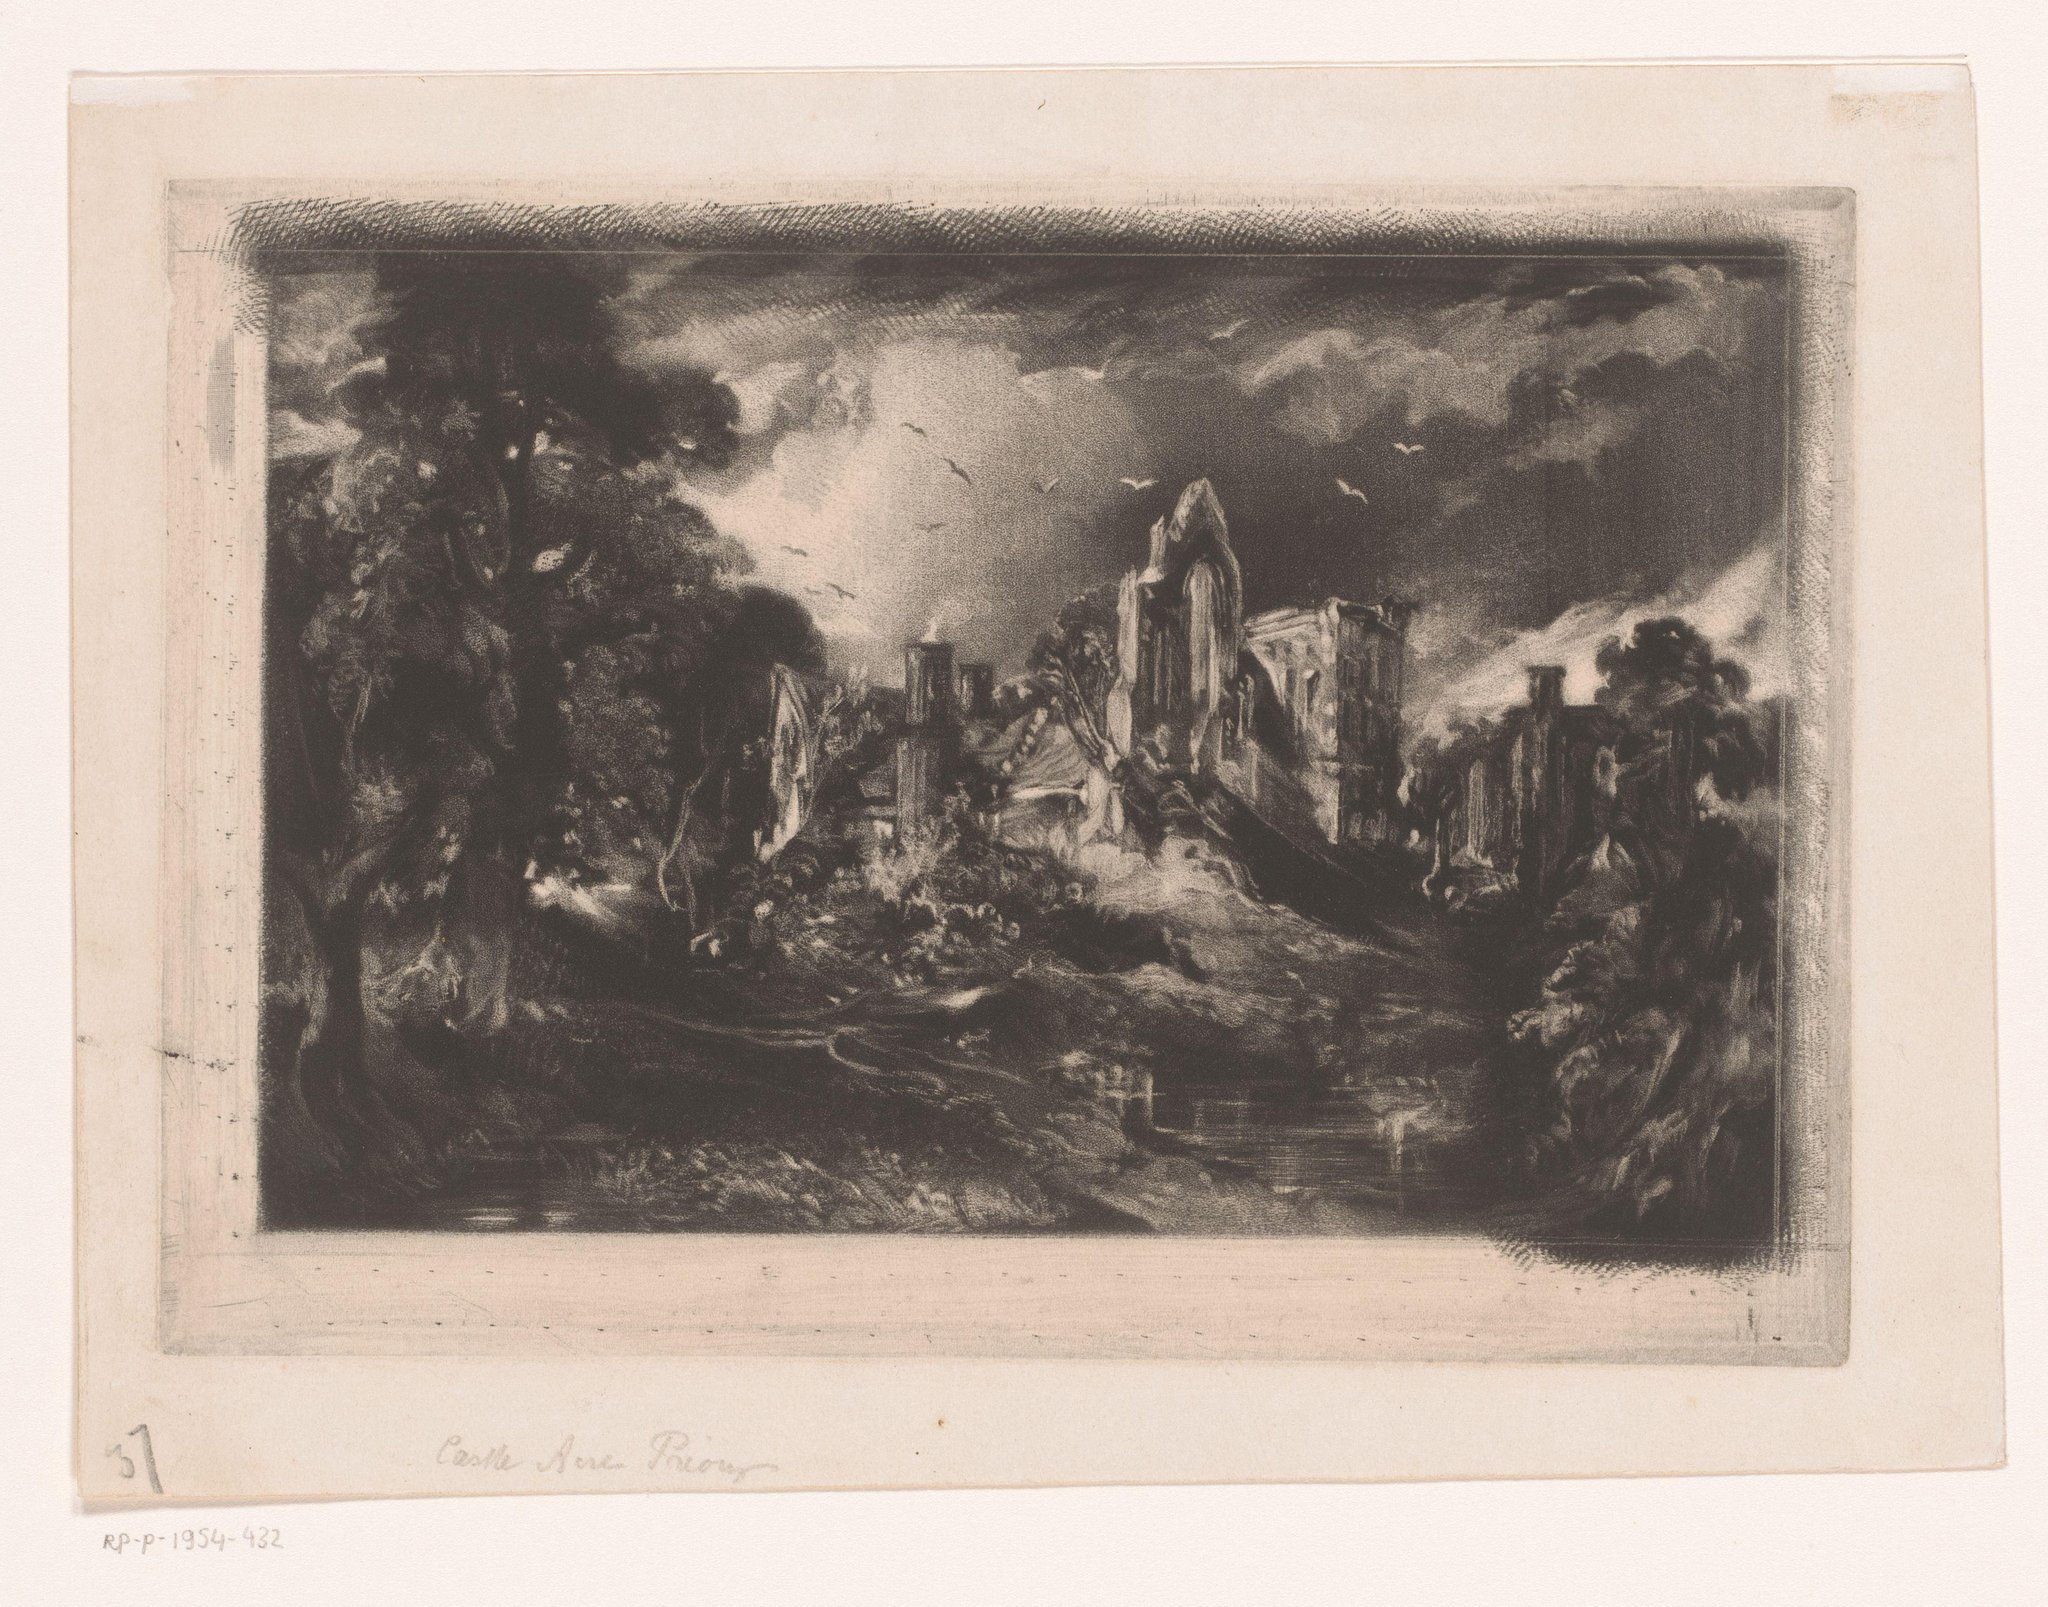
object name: print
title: Castle Acre Priory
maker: david lucas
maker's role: print maker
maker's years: 1802-1881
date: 1818-1881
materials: paper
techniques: mezzotint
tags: castle, low hill country (+ landscape with figures, staffage)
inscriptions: collector's mark: Lugt 2228, collector's mark: Lugt 2760